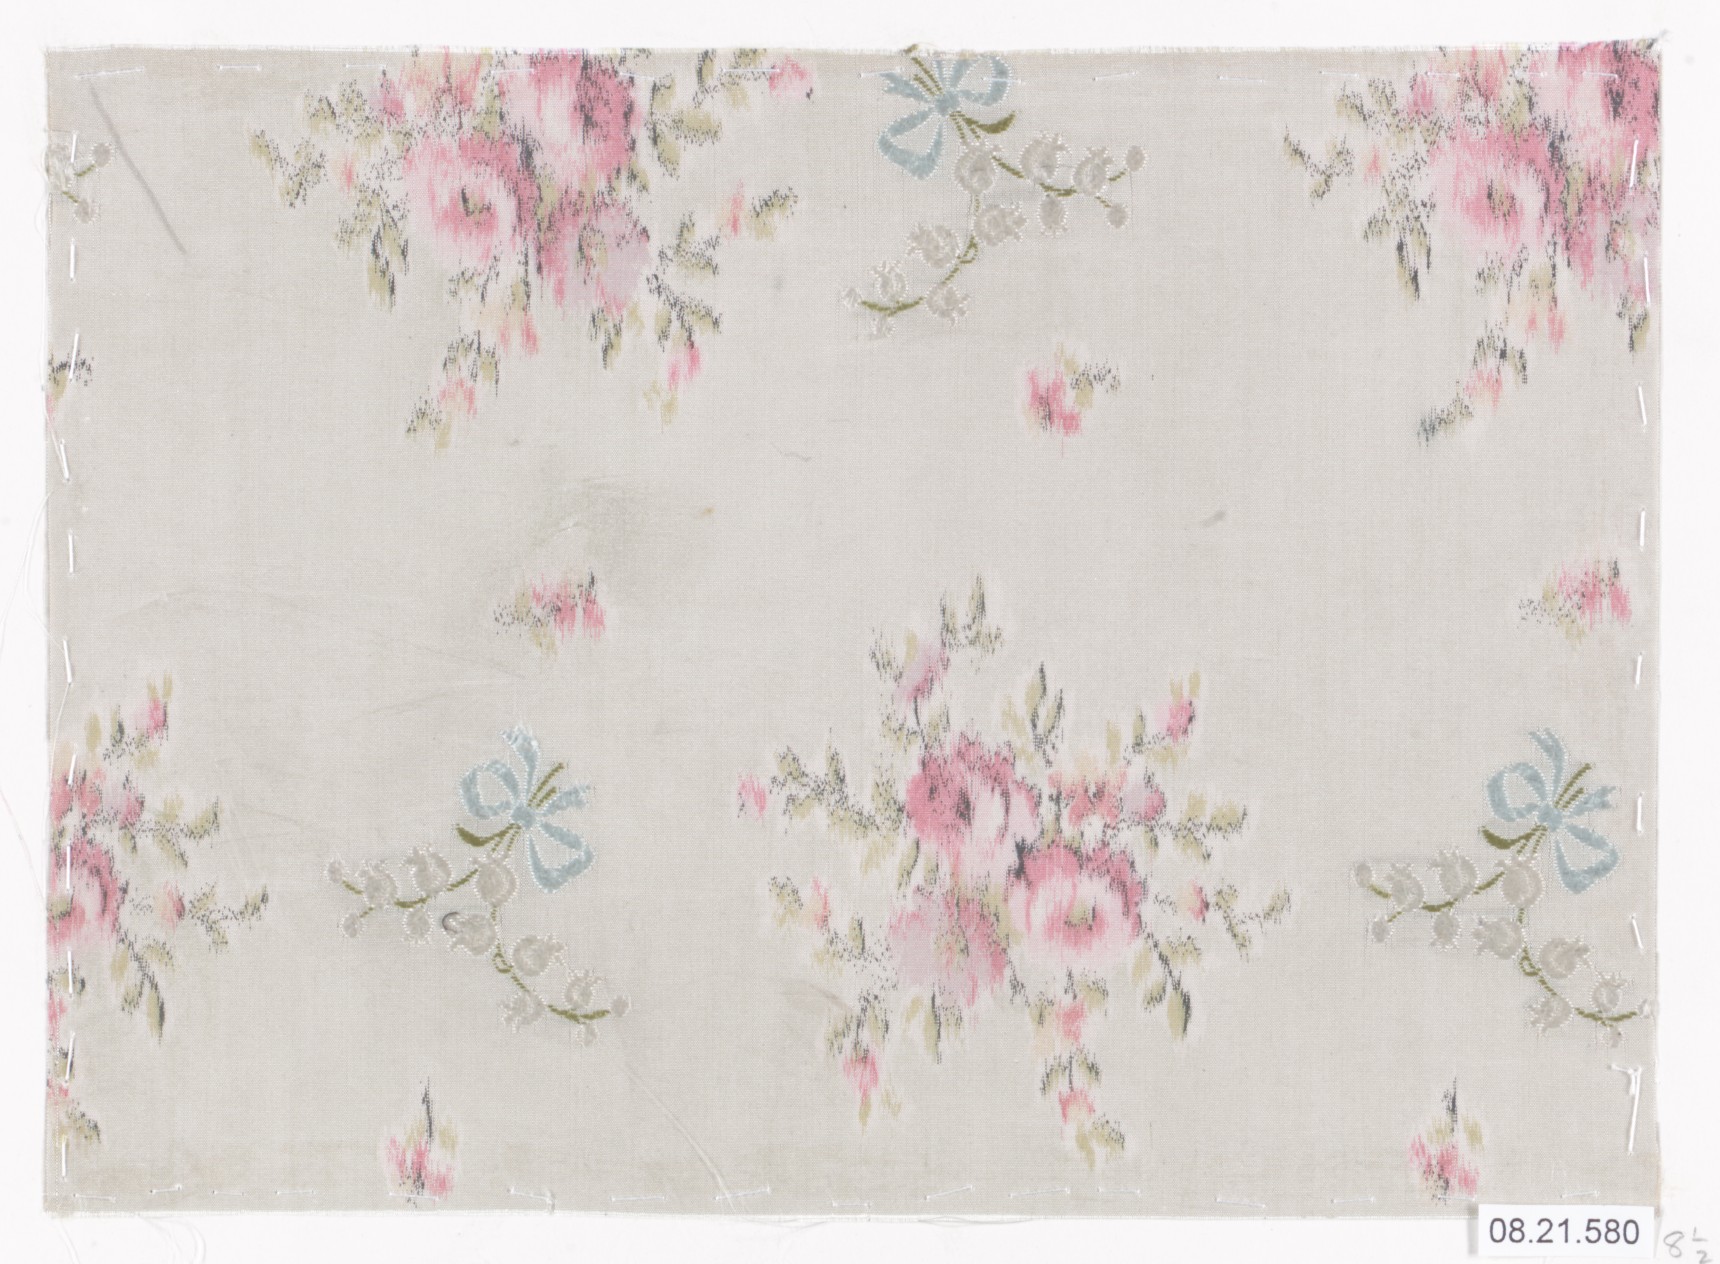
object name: textile sample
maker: Anonymous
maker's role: designer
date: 1900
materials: silk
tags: flowers